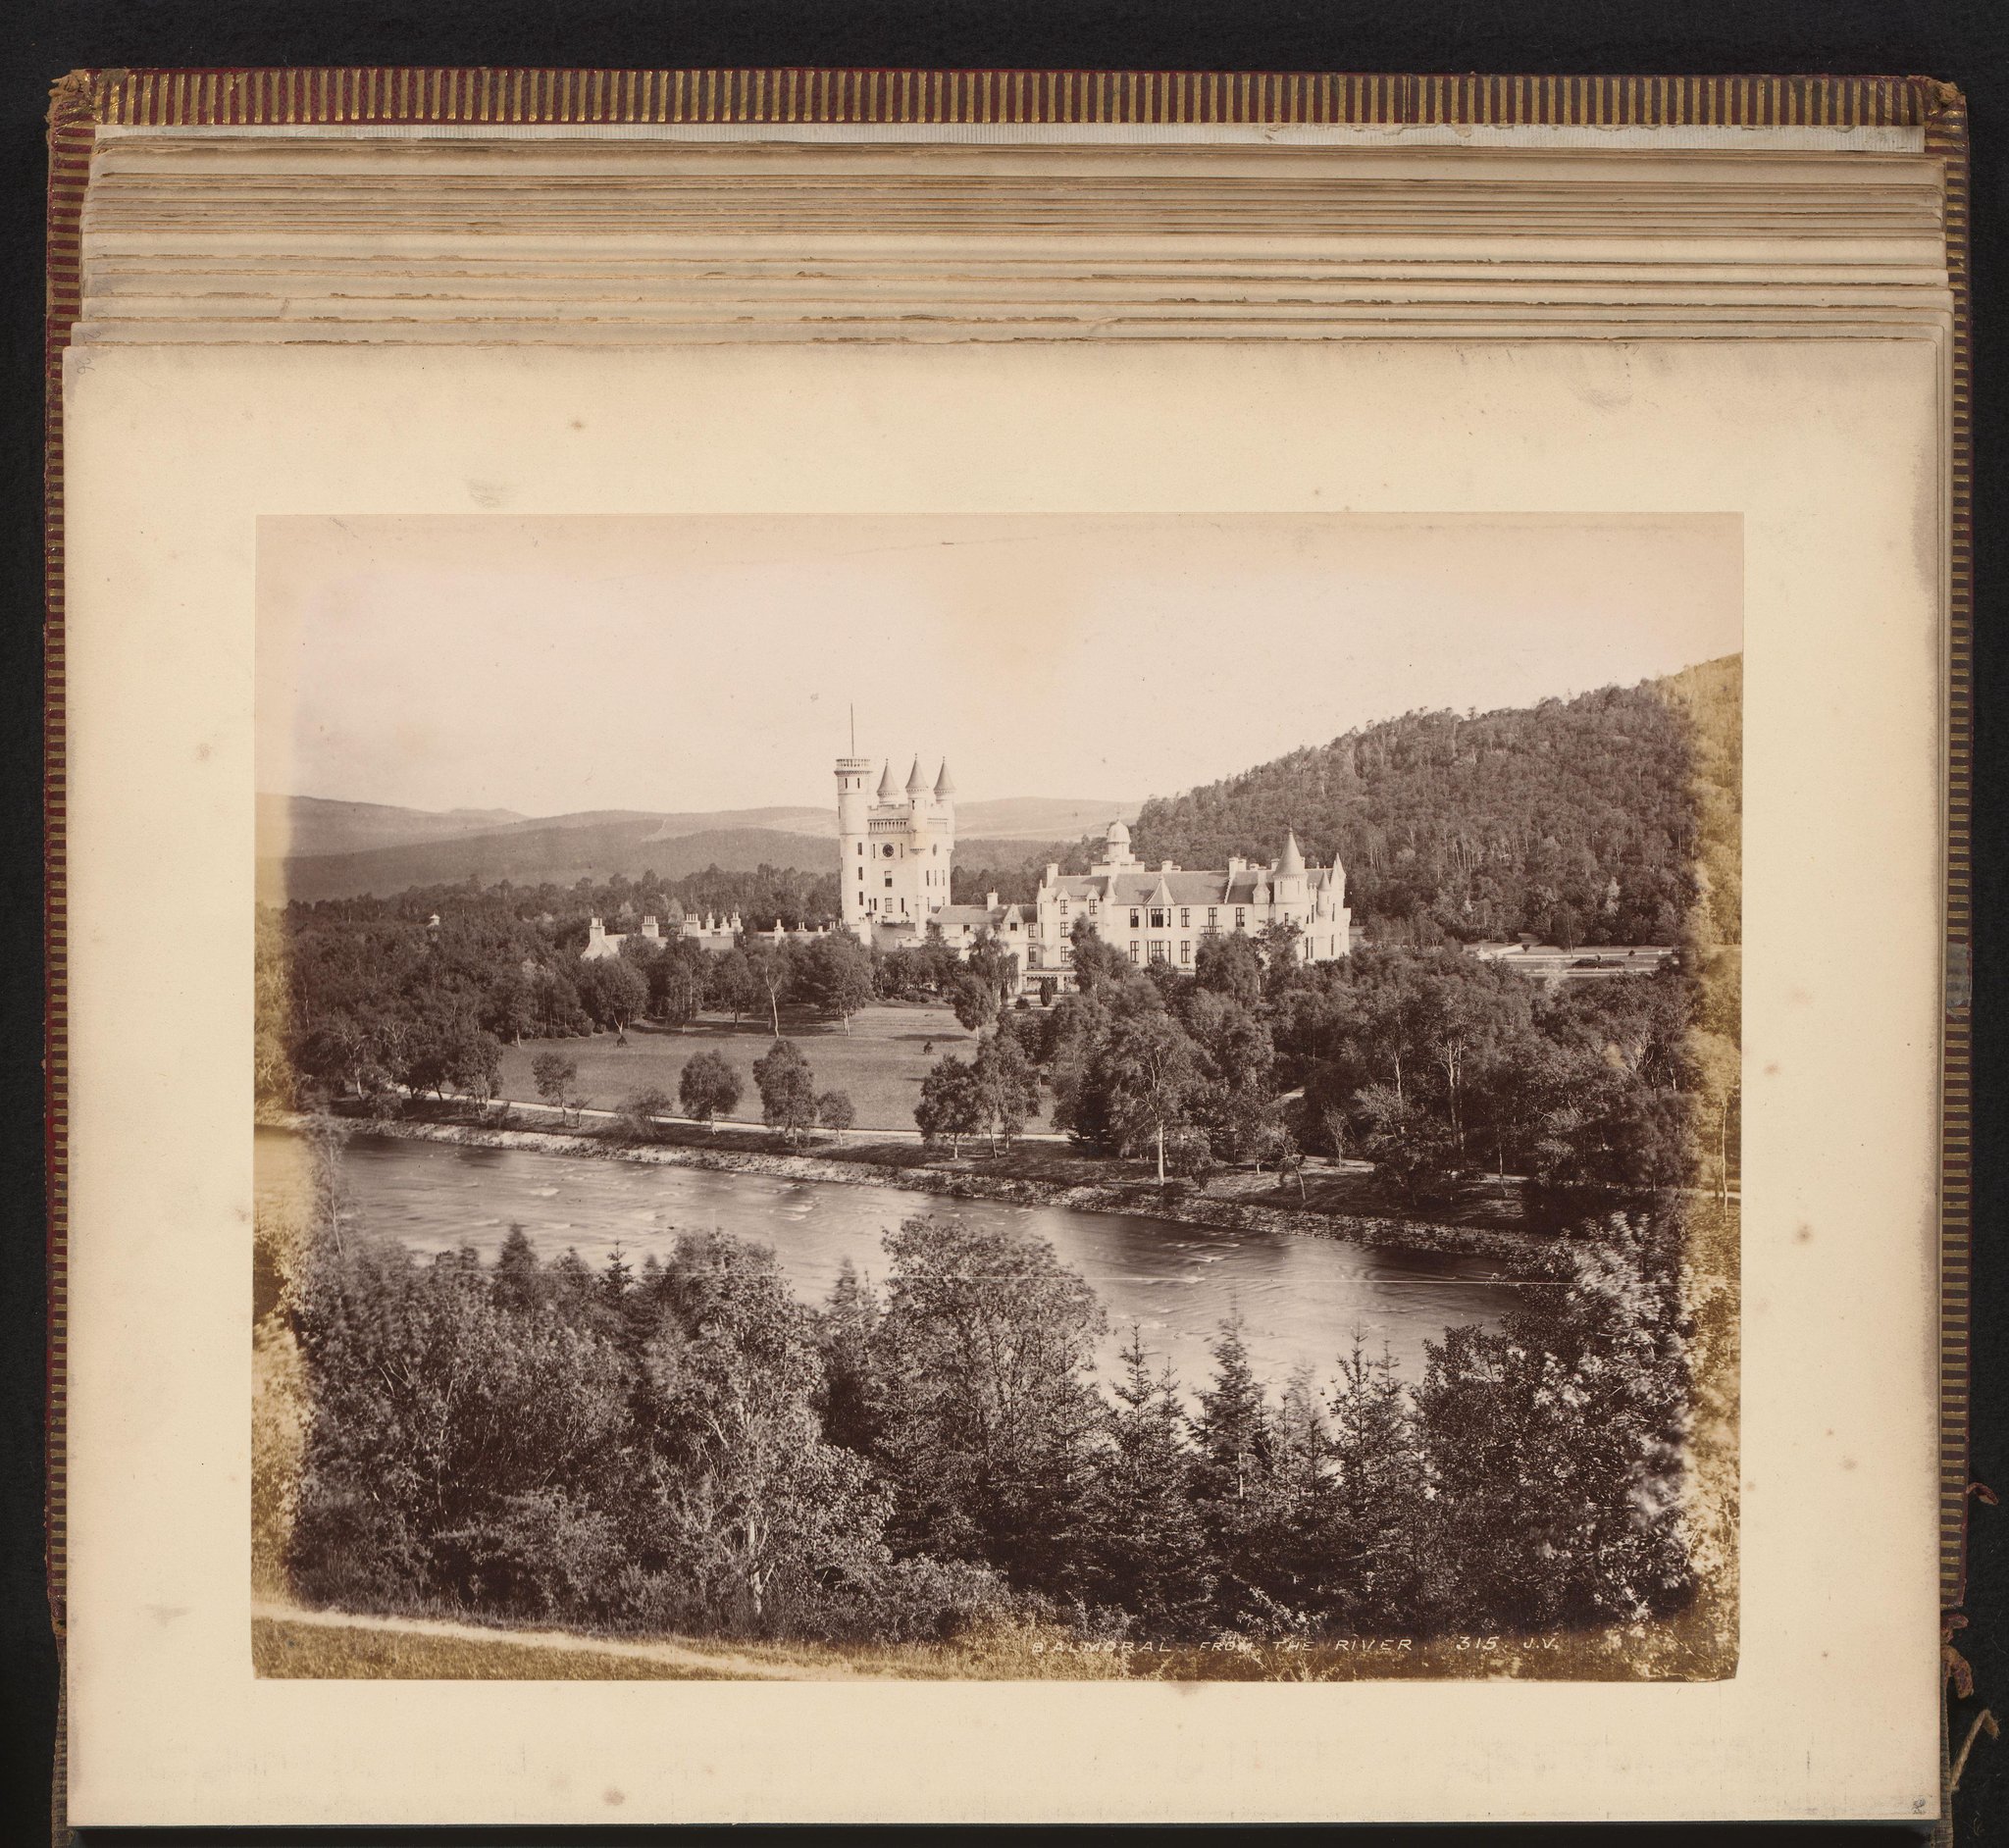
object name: photograph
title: Balmoral, from the river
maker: Anonymous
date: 1875-1885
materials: photographic support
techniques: albumen print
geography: aberdeenshire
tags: castle, river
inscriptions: number: ‘315, J.V.’